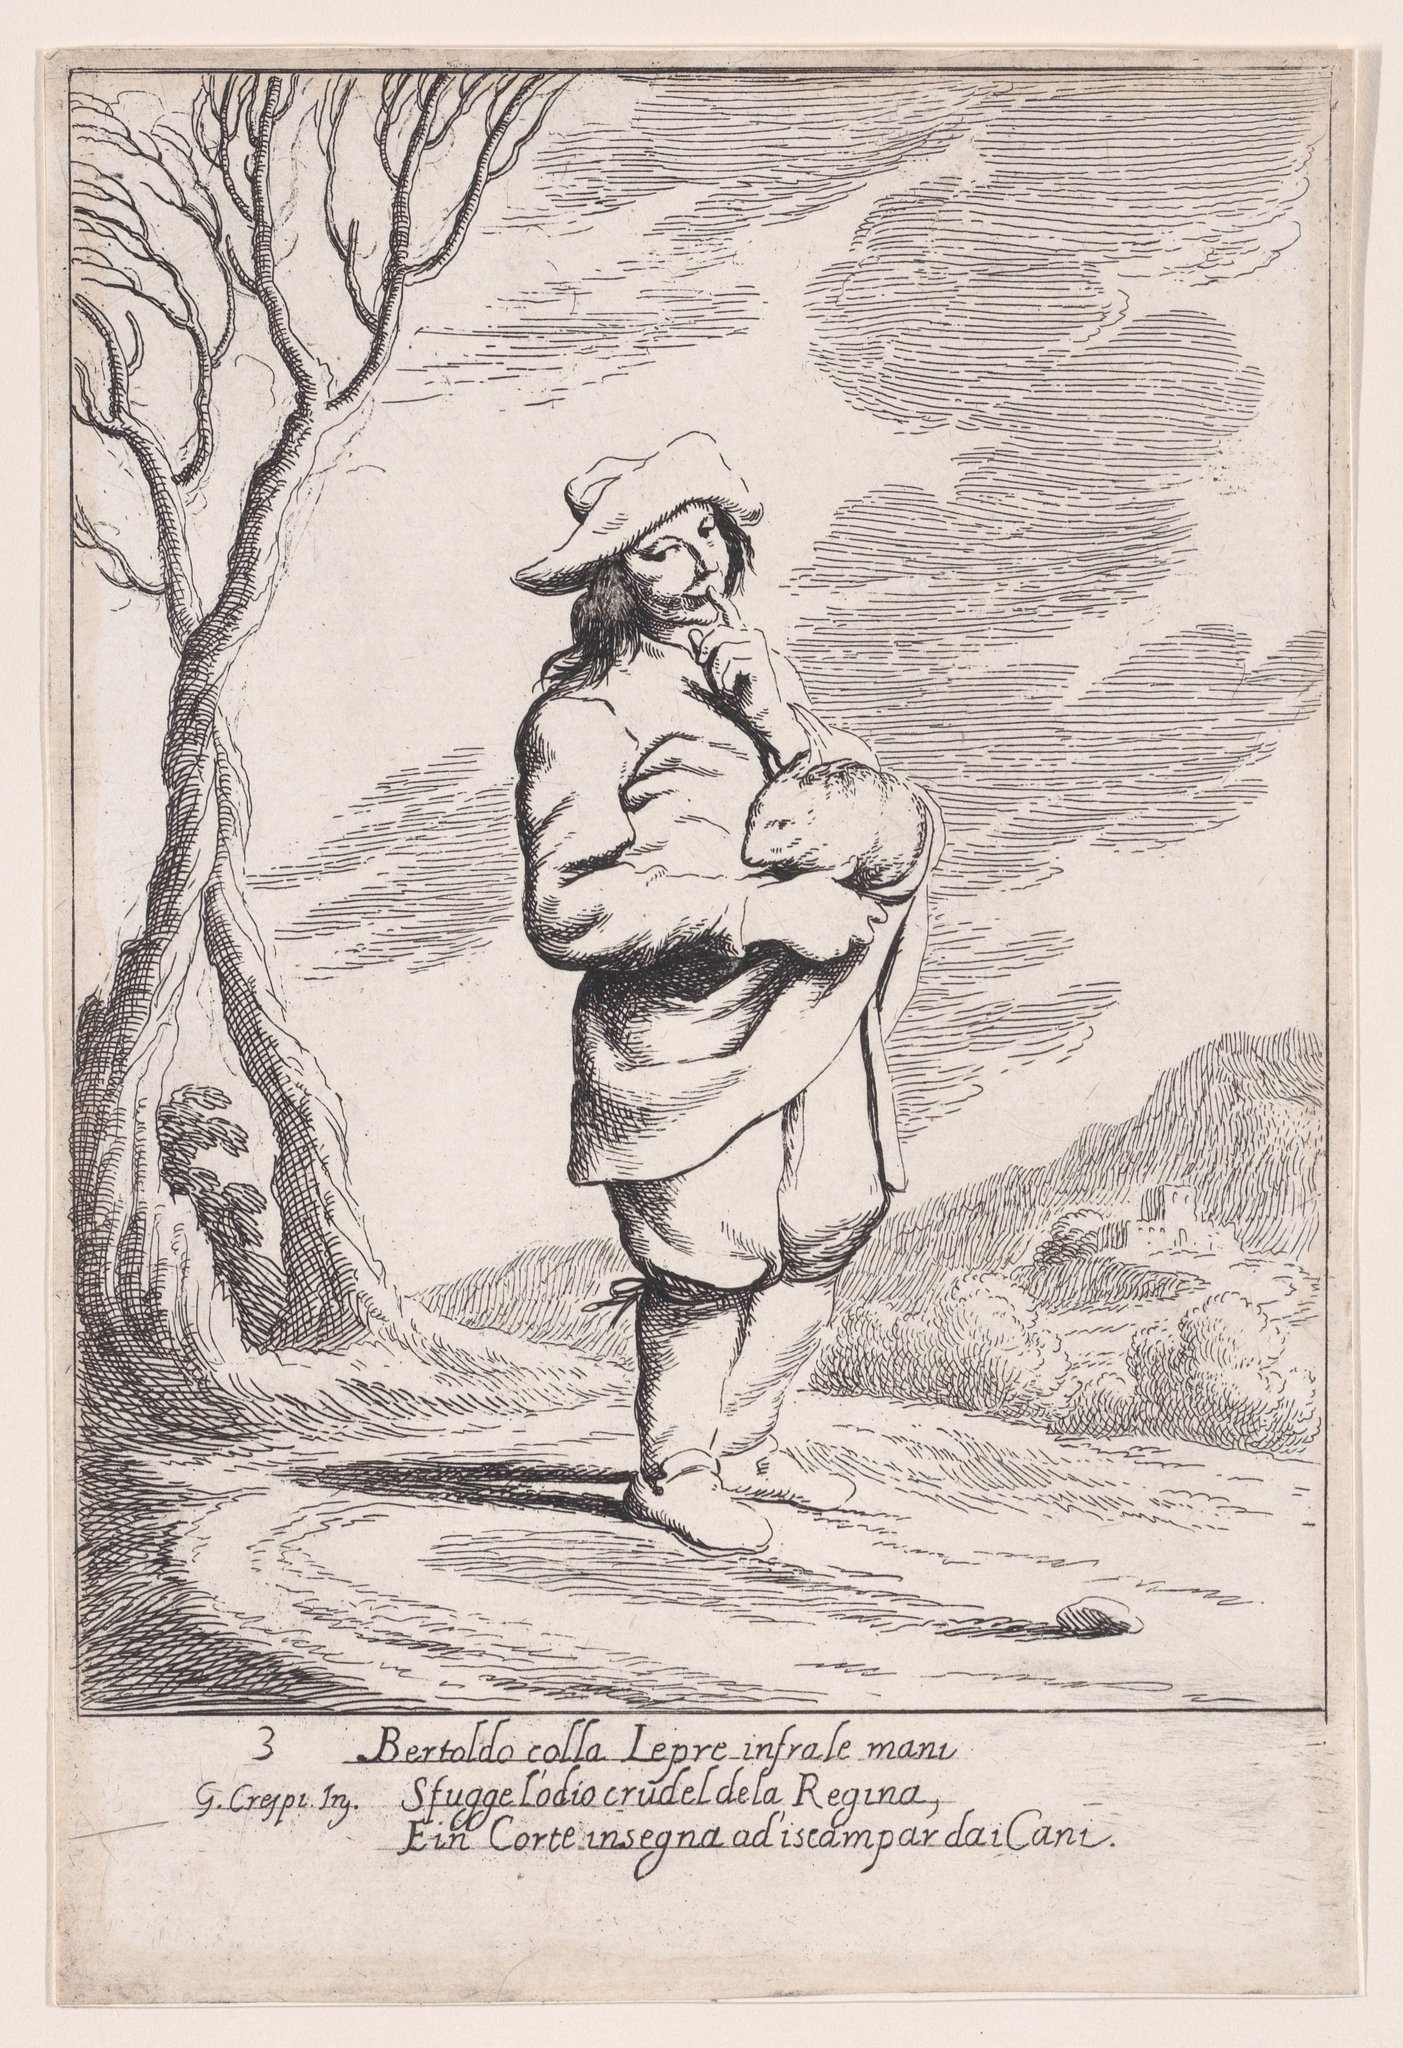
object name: print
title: Plate 3: Bertoldo holding a hare in his hand, from "Bertoldo, Bertoldino, and Cacasenno"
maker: giuseppe maria crespi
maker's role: artist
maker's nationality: italian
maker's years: 1665-1747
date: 1705-1715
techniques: etching